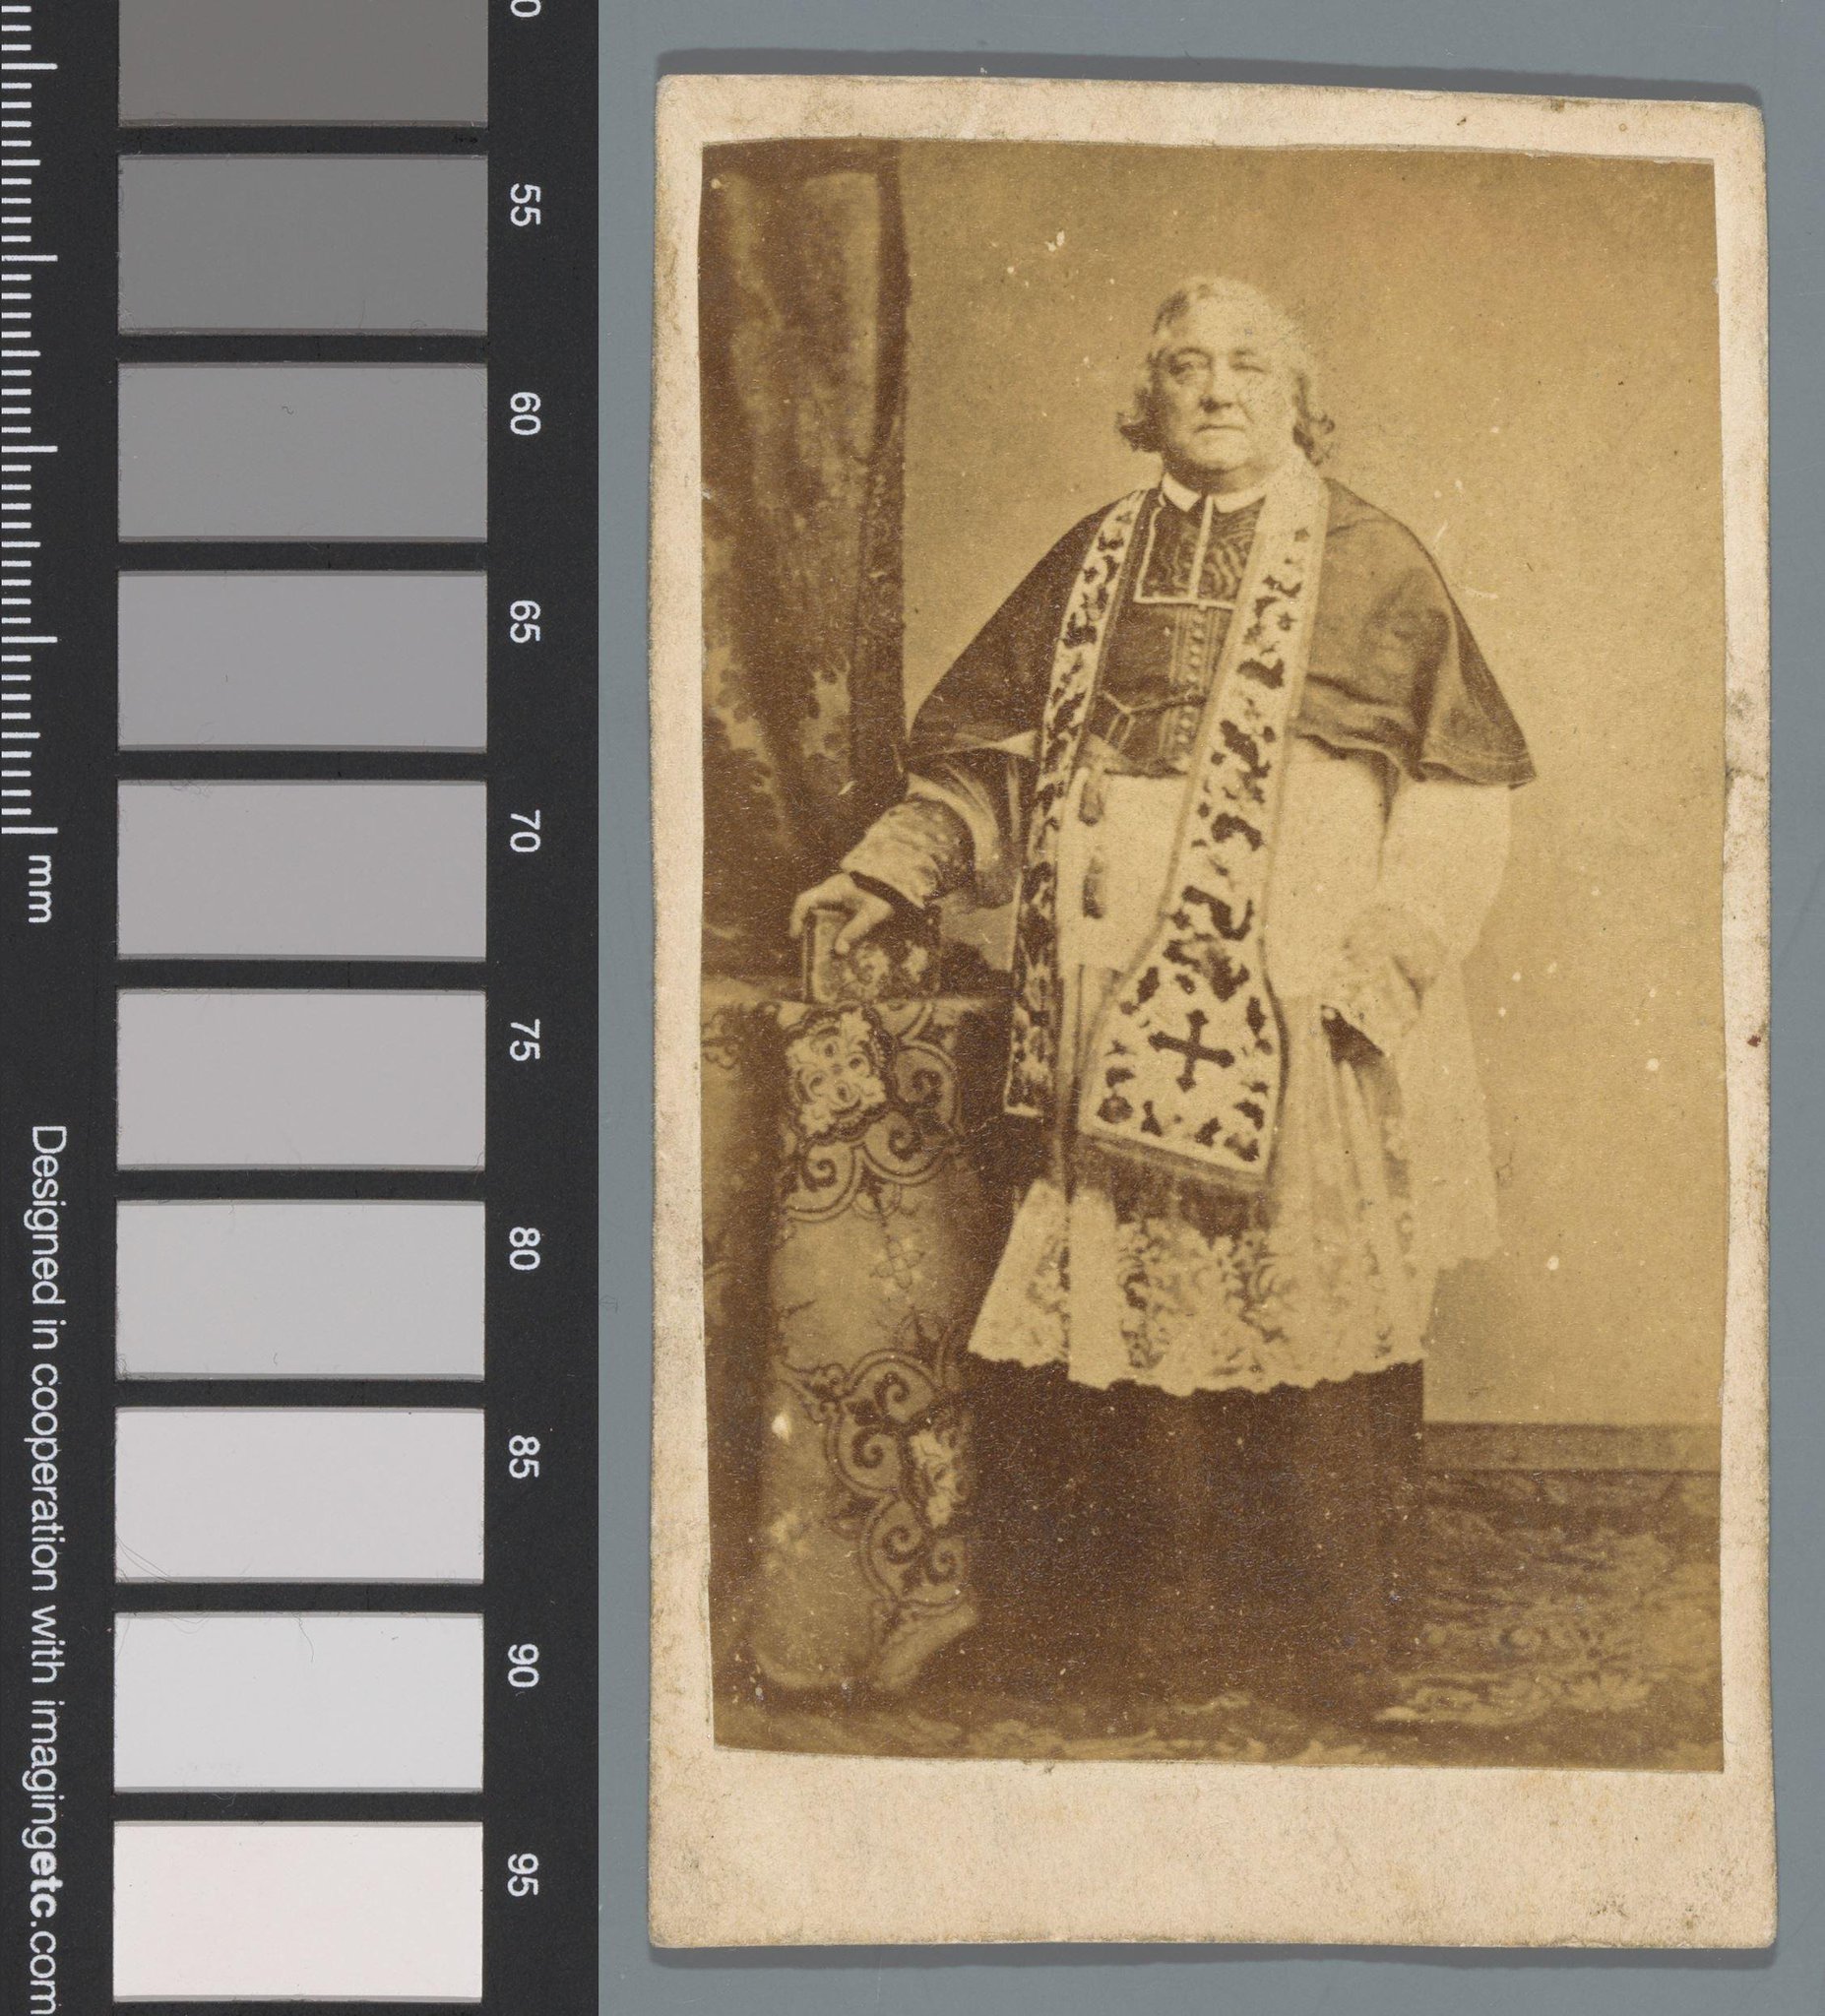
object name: carte de visite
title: Portret van een onbekende kanunnik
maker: Anonymous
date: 1855-1885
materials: cardboard, paper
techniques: albumen print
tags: priest (roman catholic), anonymous historical person portrayed